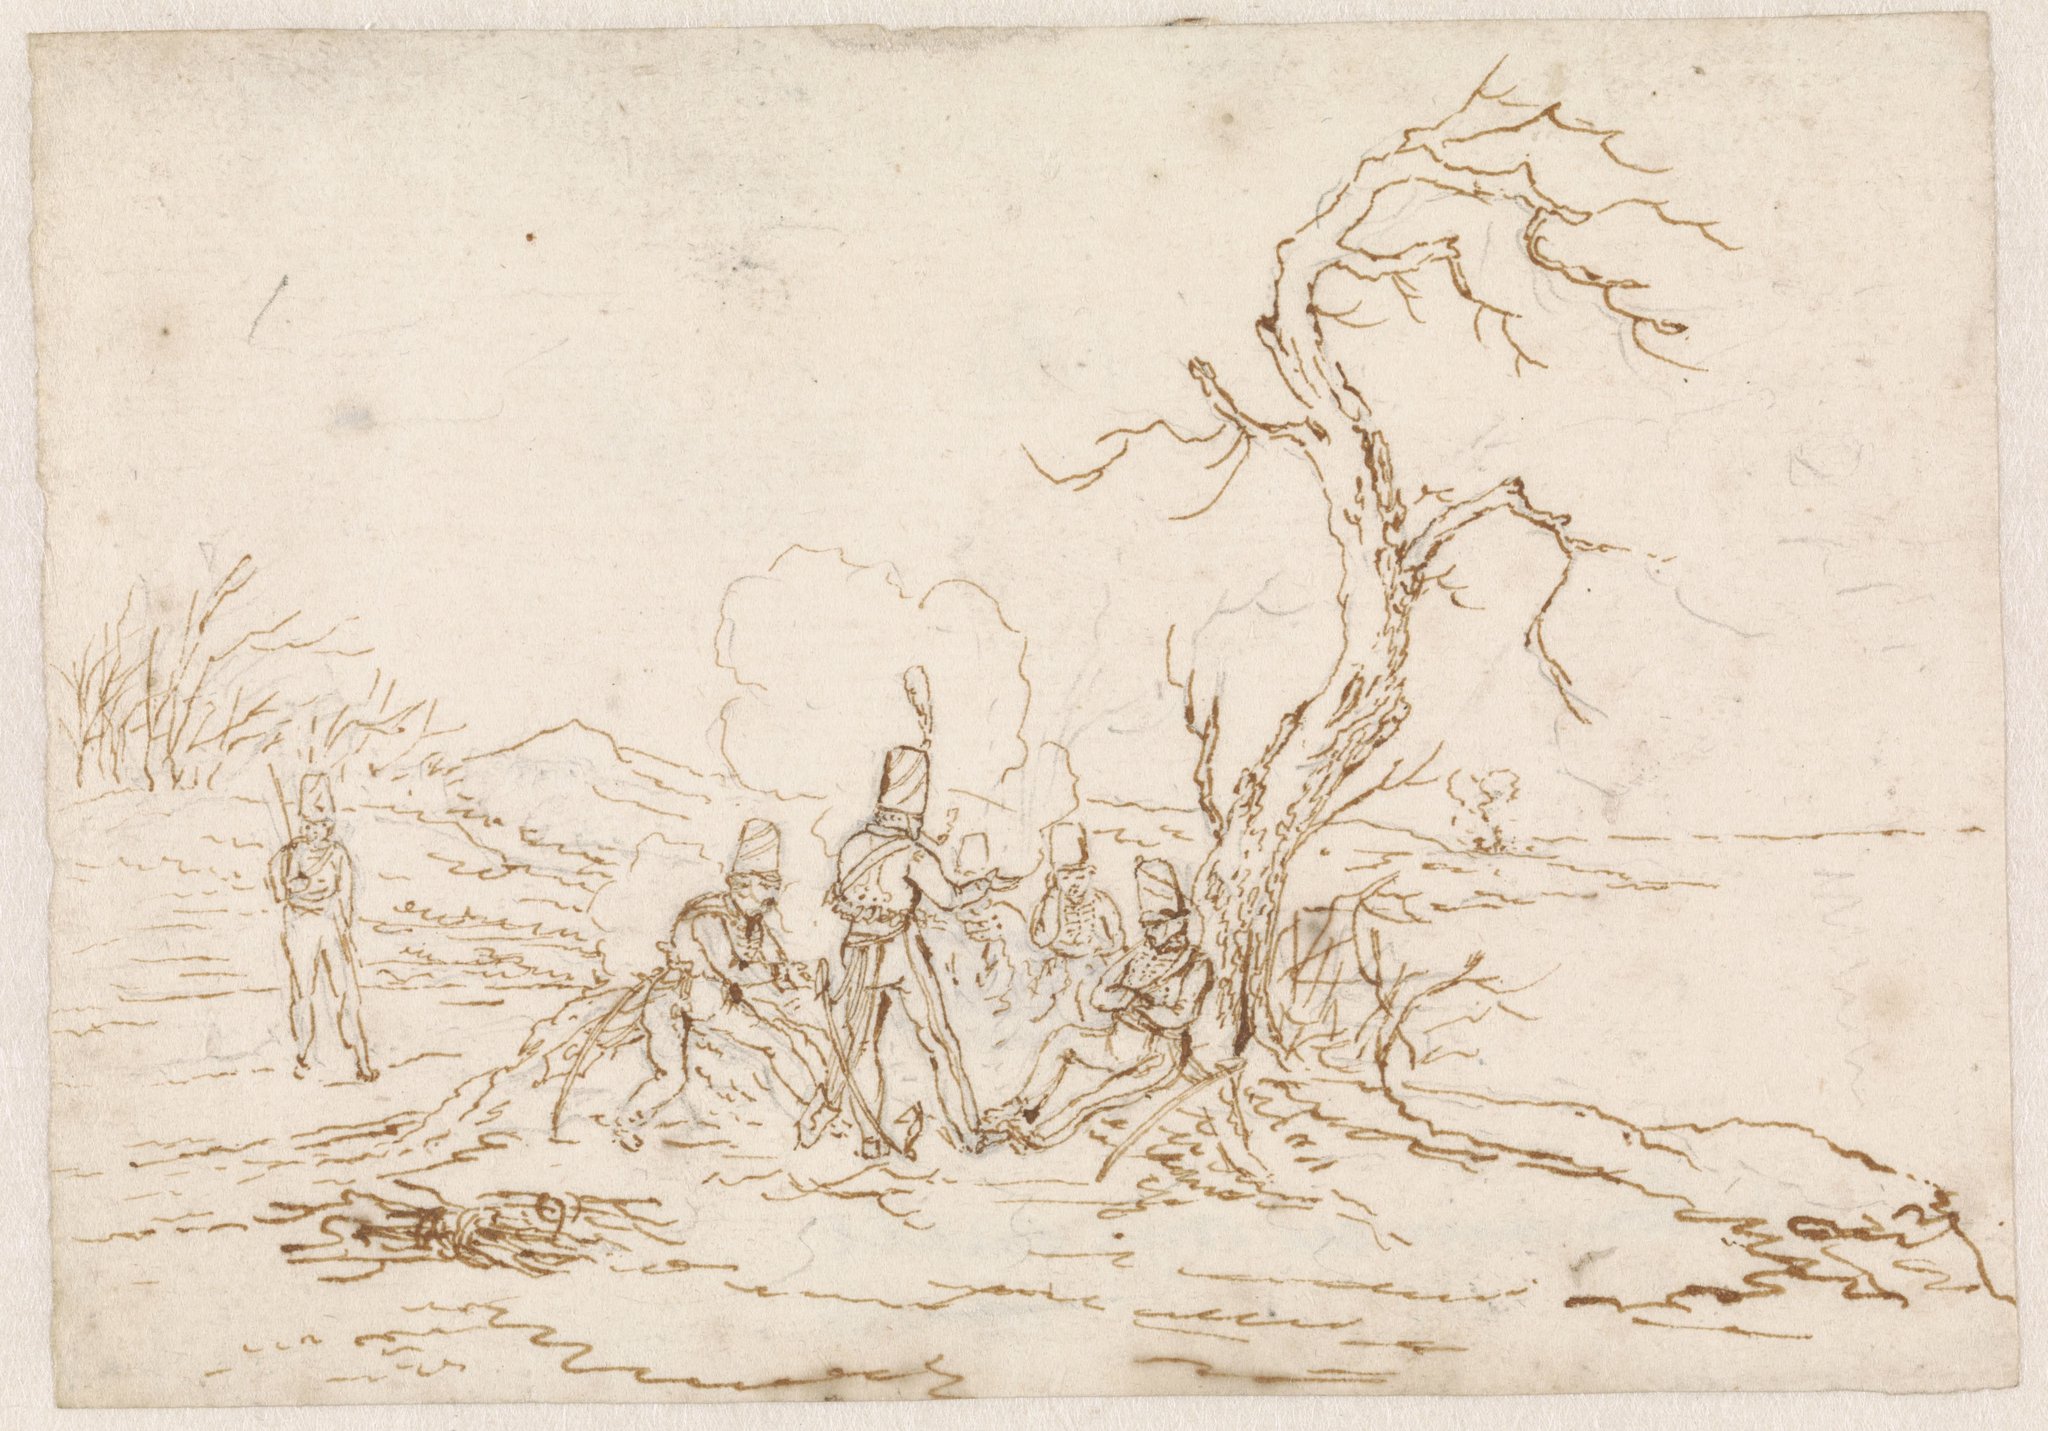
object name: drawing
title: Soldaten rond kampvuur onder een kale boom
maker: gerardus emaus de micault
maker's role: draughtsman, print maker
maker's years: 1798-1863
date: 1799-1863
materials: ink, paper, pencil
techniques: pen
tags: (military) camp with tents